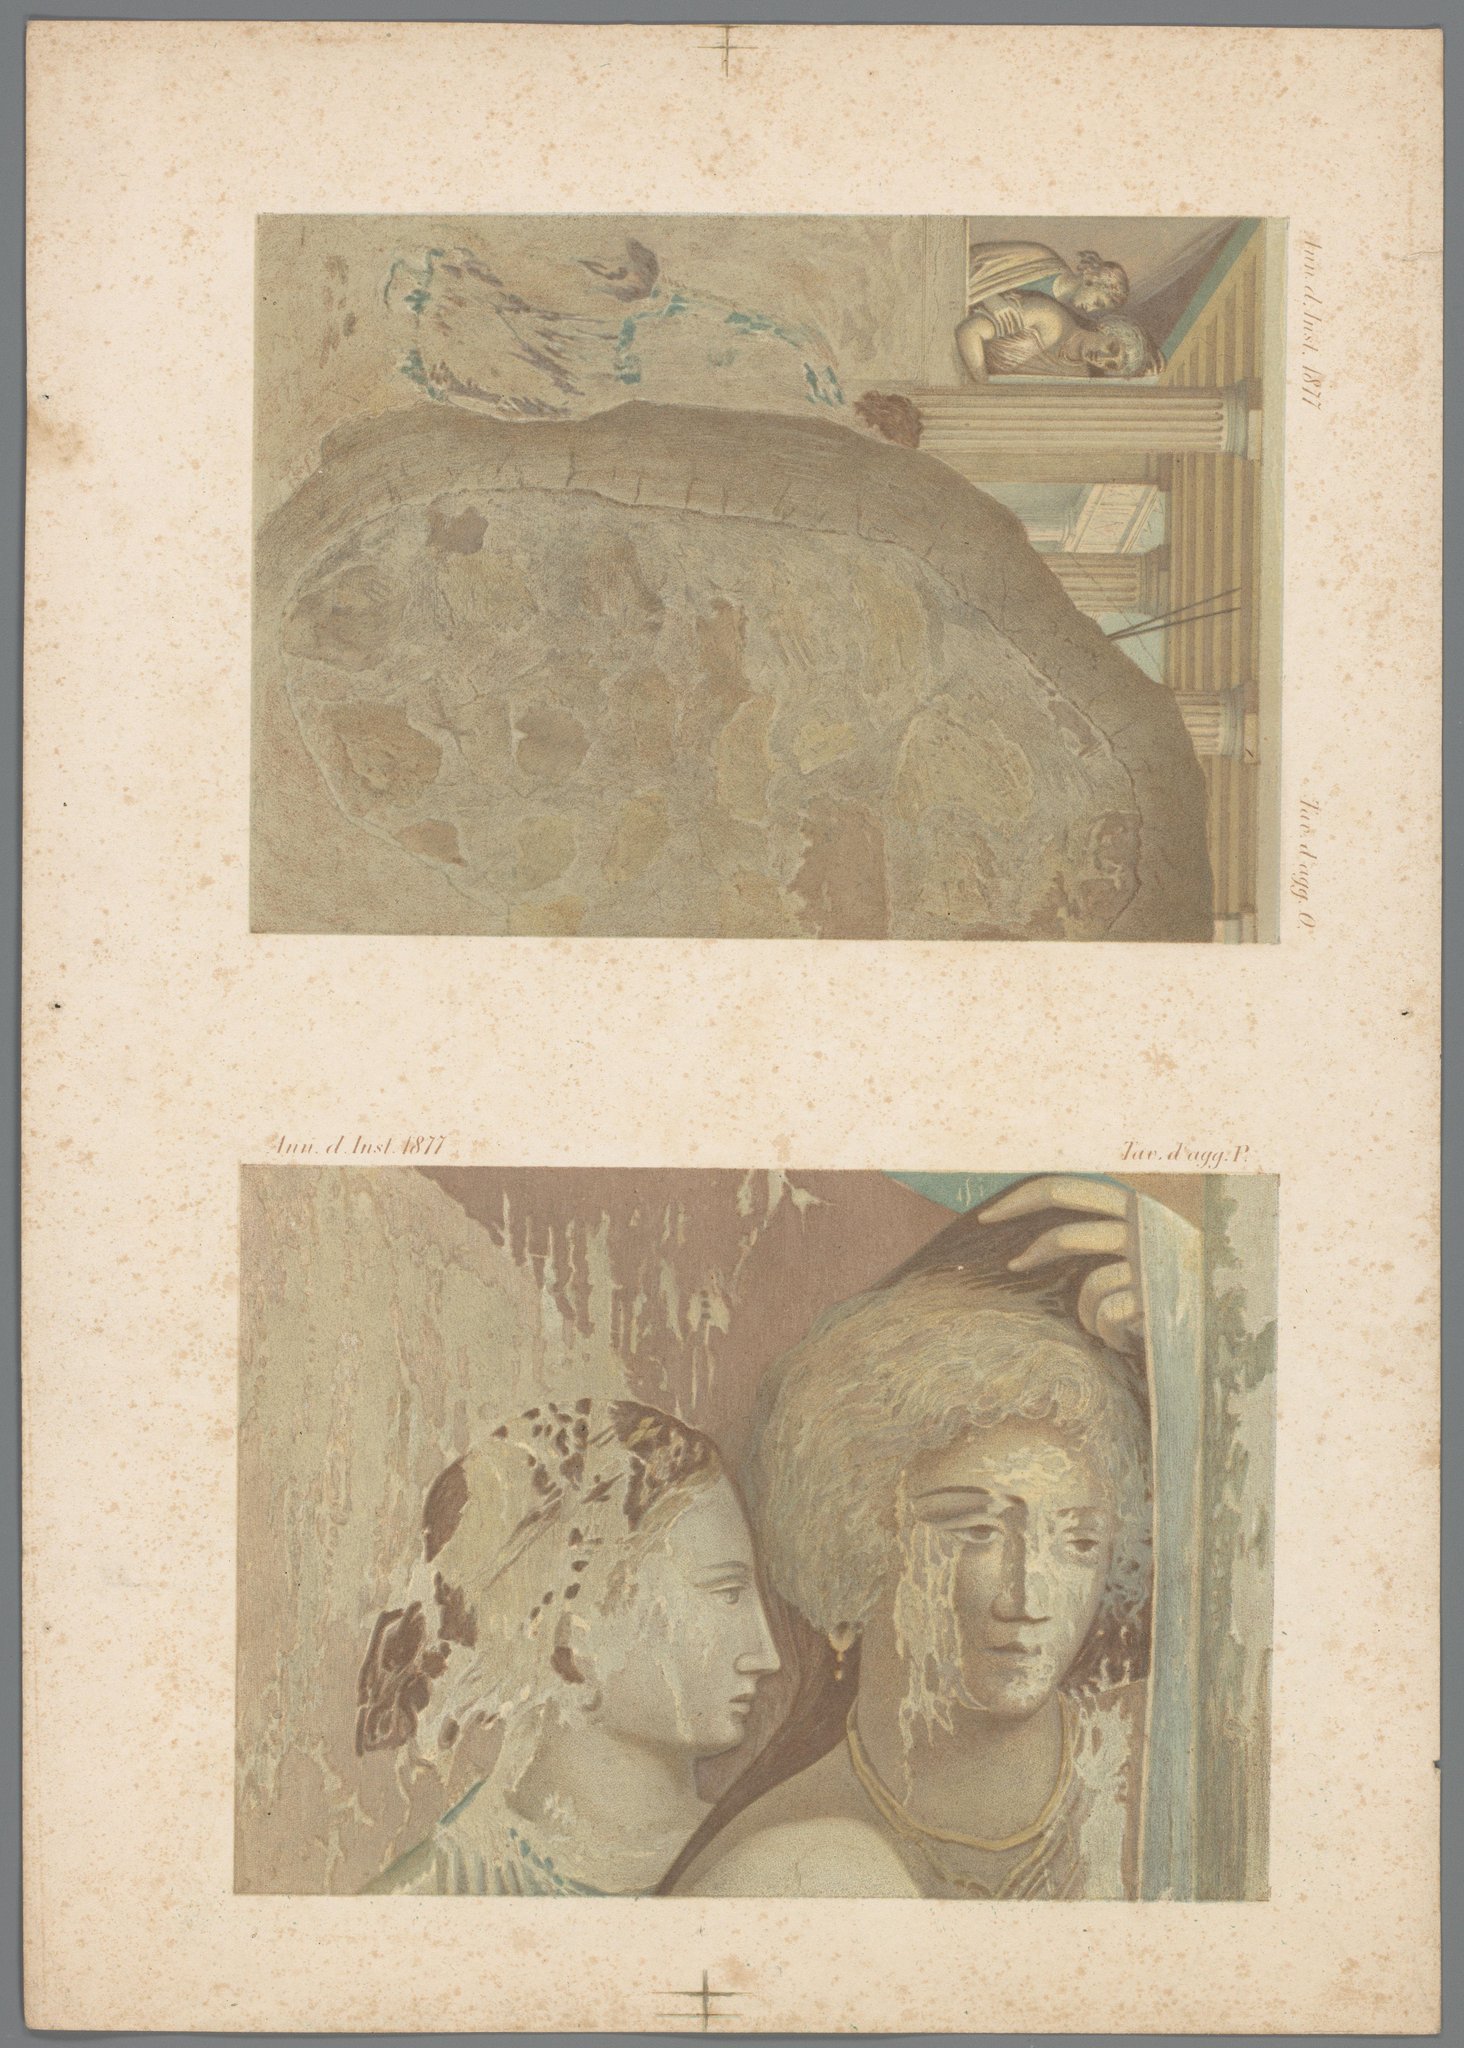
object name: print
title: Twee prenten van een Romeins fresco in Pompeï met twee vrouwen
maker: Anonymous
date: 1877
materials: paper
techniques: lithograph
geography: pompeii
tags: adult woman, column, pillar ~ architecture, pompeii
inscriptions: inscription: ‘Tav. d'agg. P.’, inscription: ‘Tav. d'agg. O.’